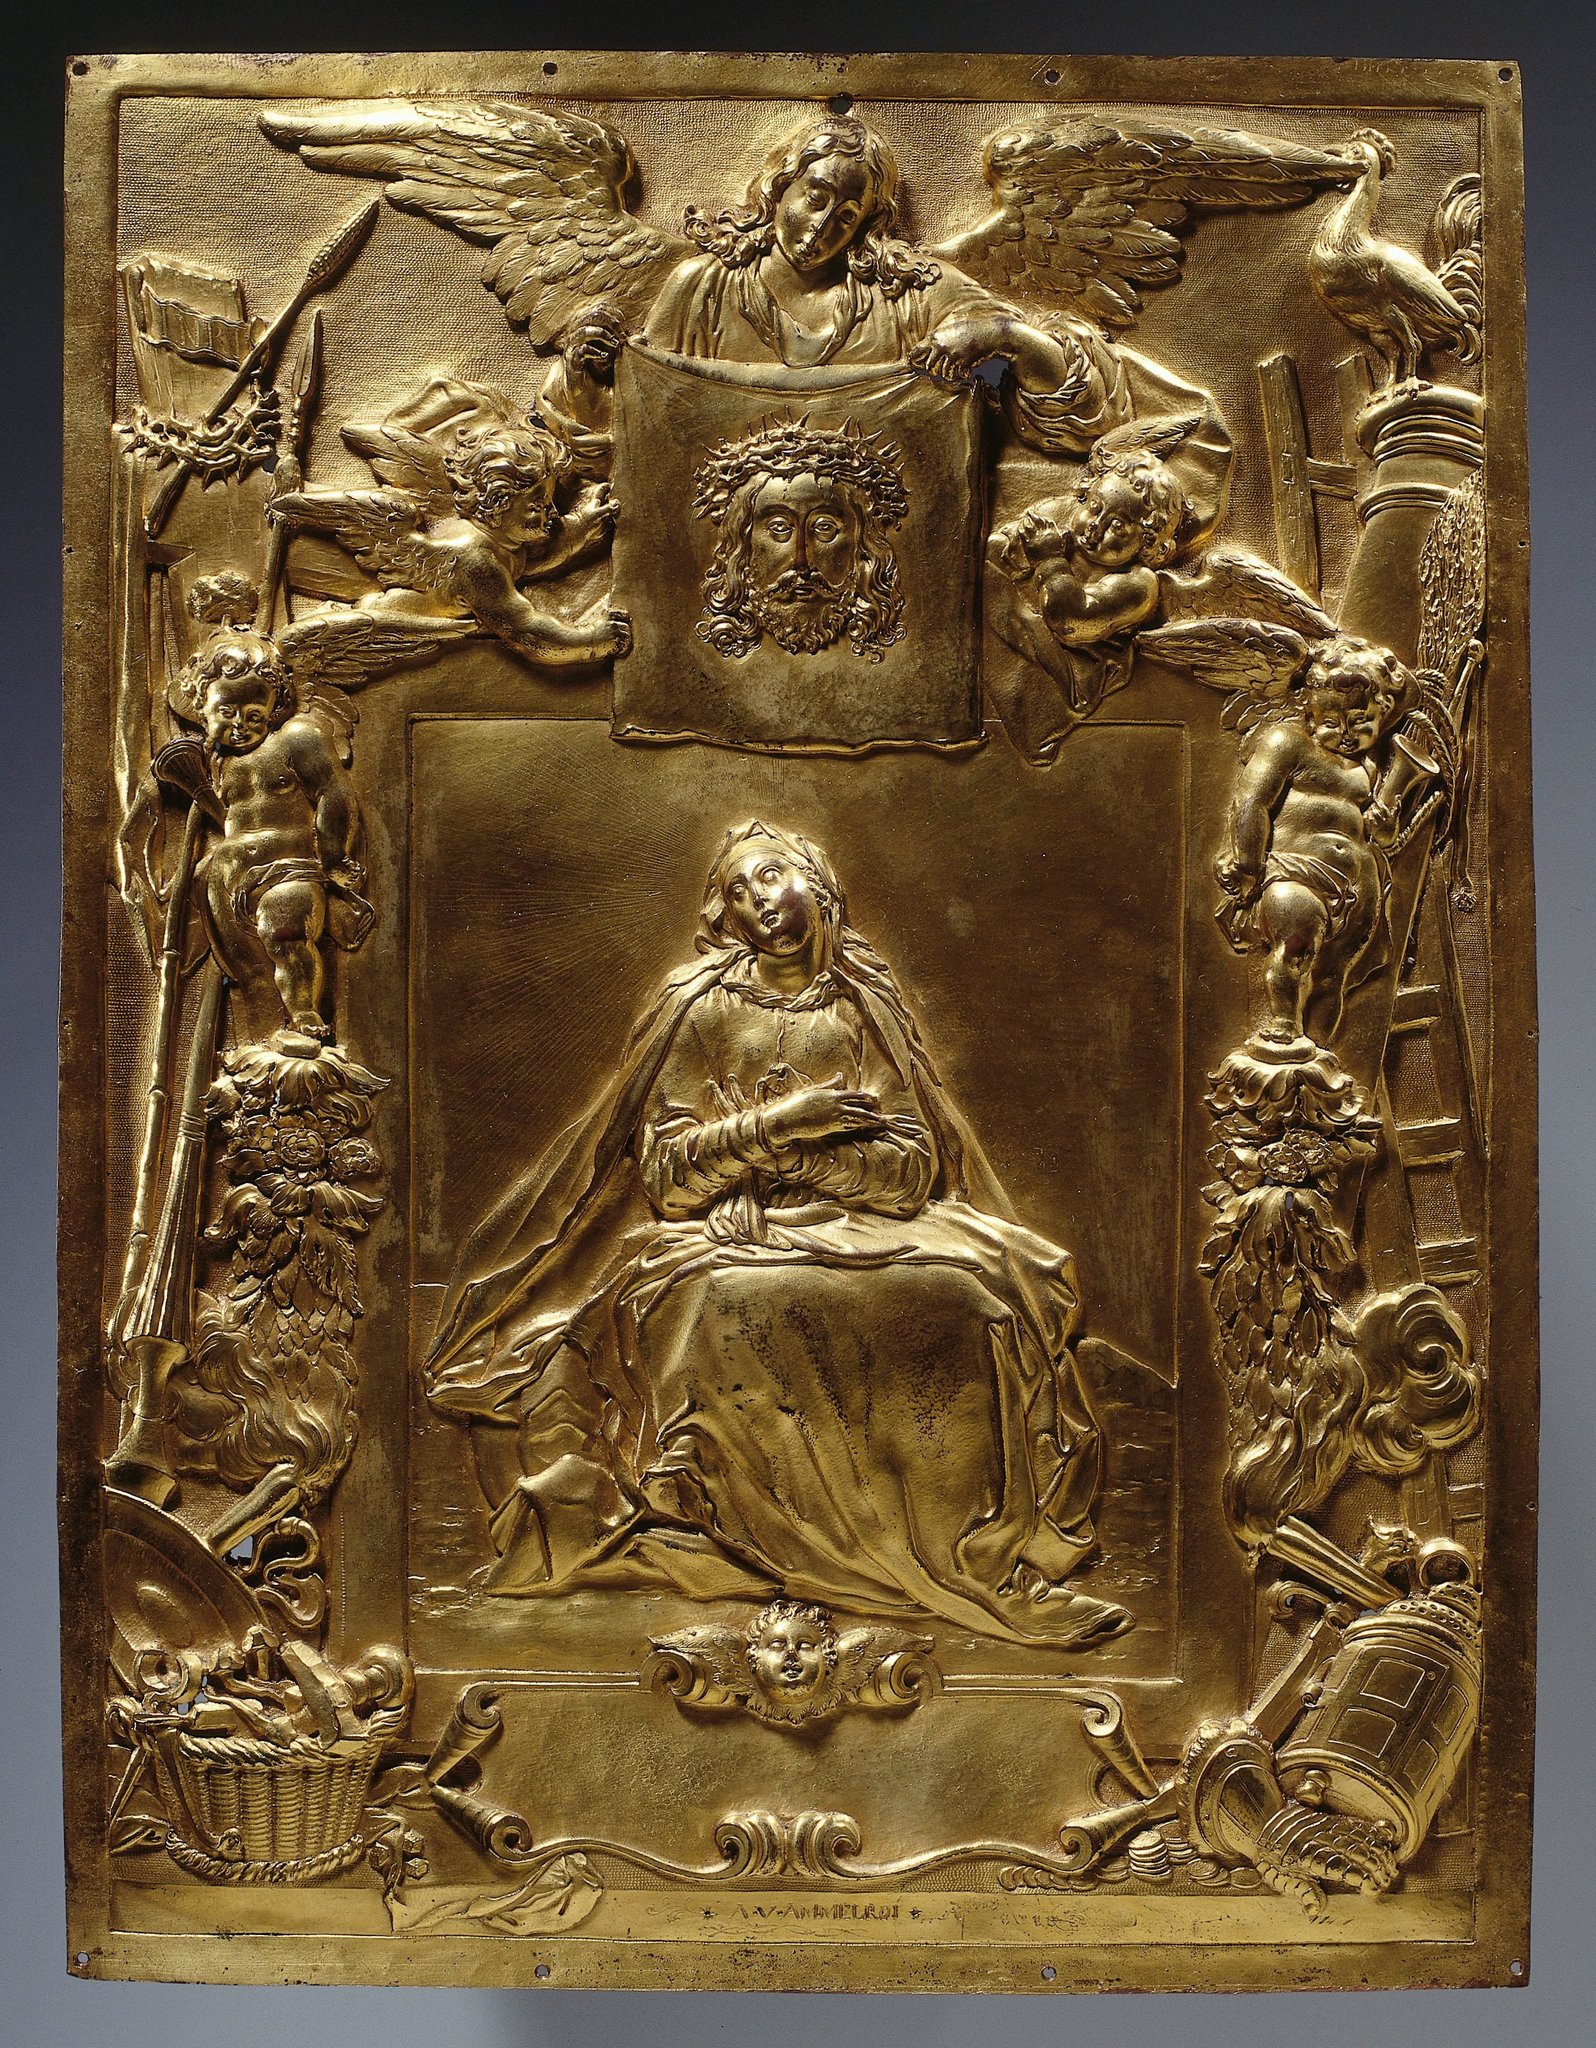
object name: tabernakeldeur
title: Tabernakeldeur met voorstelling van Maria als moeder van smarten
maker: adriaen van ammelroi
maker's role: silversmith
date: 1616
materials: copper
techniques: metalworking, gilding, punching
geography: utrecht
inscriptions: signature: ‘A. V. AMMELROI.’, date: ‘Ano 1616’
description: Het reliëf is uit rood koperplaat gedreven, geciseleerd en geponst bewerkt en vervolgens aan de voorzijde verguld. In het midden is Maria als moeder van smarten weergegeven; gezeten, de armen voor de borst gekruist, het hoofd en de blik omhoog gericht. In de omlijsting is bovenaan het sudarium opgenomen, de zweetdoek van de H. Veronica met de beeltenis van Christus met de doornenkroon. De doek wordt opgehouden door een engel die wordt bijgestaan door twee putti. Links en rechts twee engeltjes, staande op guirlandes met bloemen, alsmede de lijdenswerktuigen, te weten van linksonder naar boven: de mand met de nagels, de hamer en de tang, waarachter een doek met de dobbelstenen, het schild, de lans, het riet met de edikspons, het kruis met de doornenkroon, de stok en de doek, rechts onder de zilverlingen, de handschoen, de lantaarn, het zwaard, de fakkel, de ladder, het koord, de gesel, de roede, de zuil en de haan. Onderaan een blanke cartouche, omgeven door rolwerk met een cherubkopje. Onder de cartouche de signatuur: A. V. AMMELROI. Ano 1616. Boven en onderaan telkens vier gaten alsmede een ga t boven de kop van de engel, ter bevestiging van het reliëf op de drager. Op enkele plaatsen, o.a. bij de rechterhand van de engel, is de plaat gescheurd.